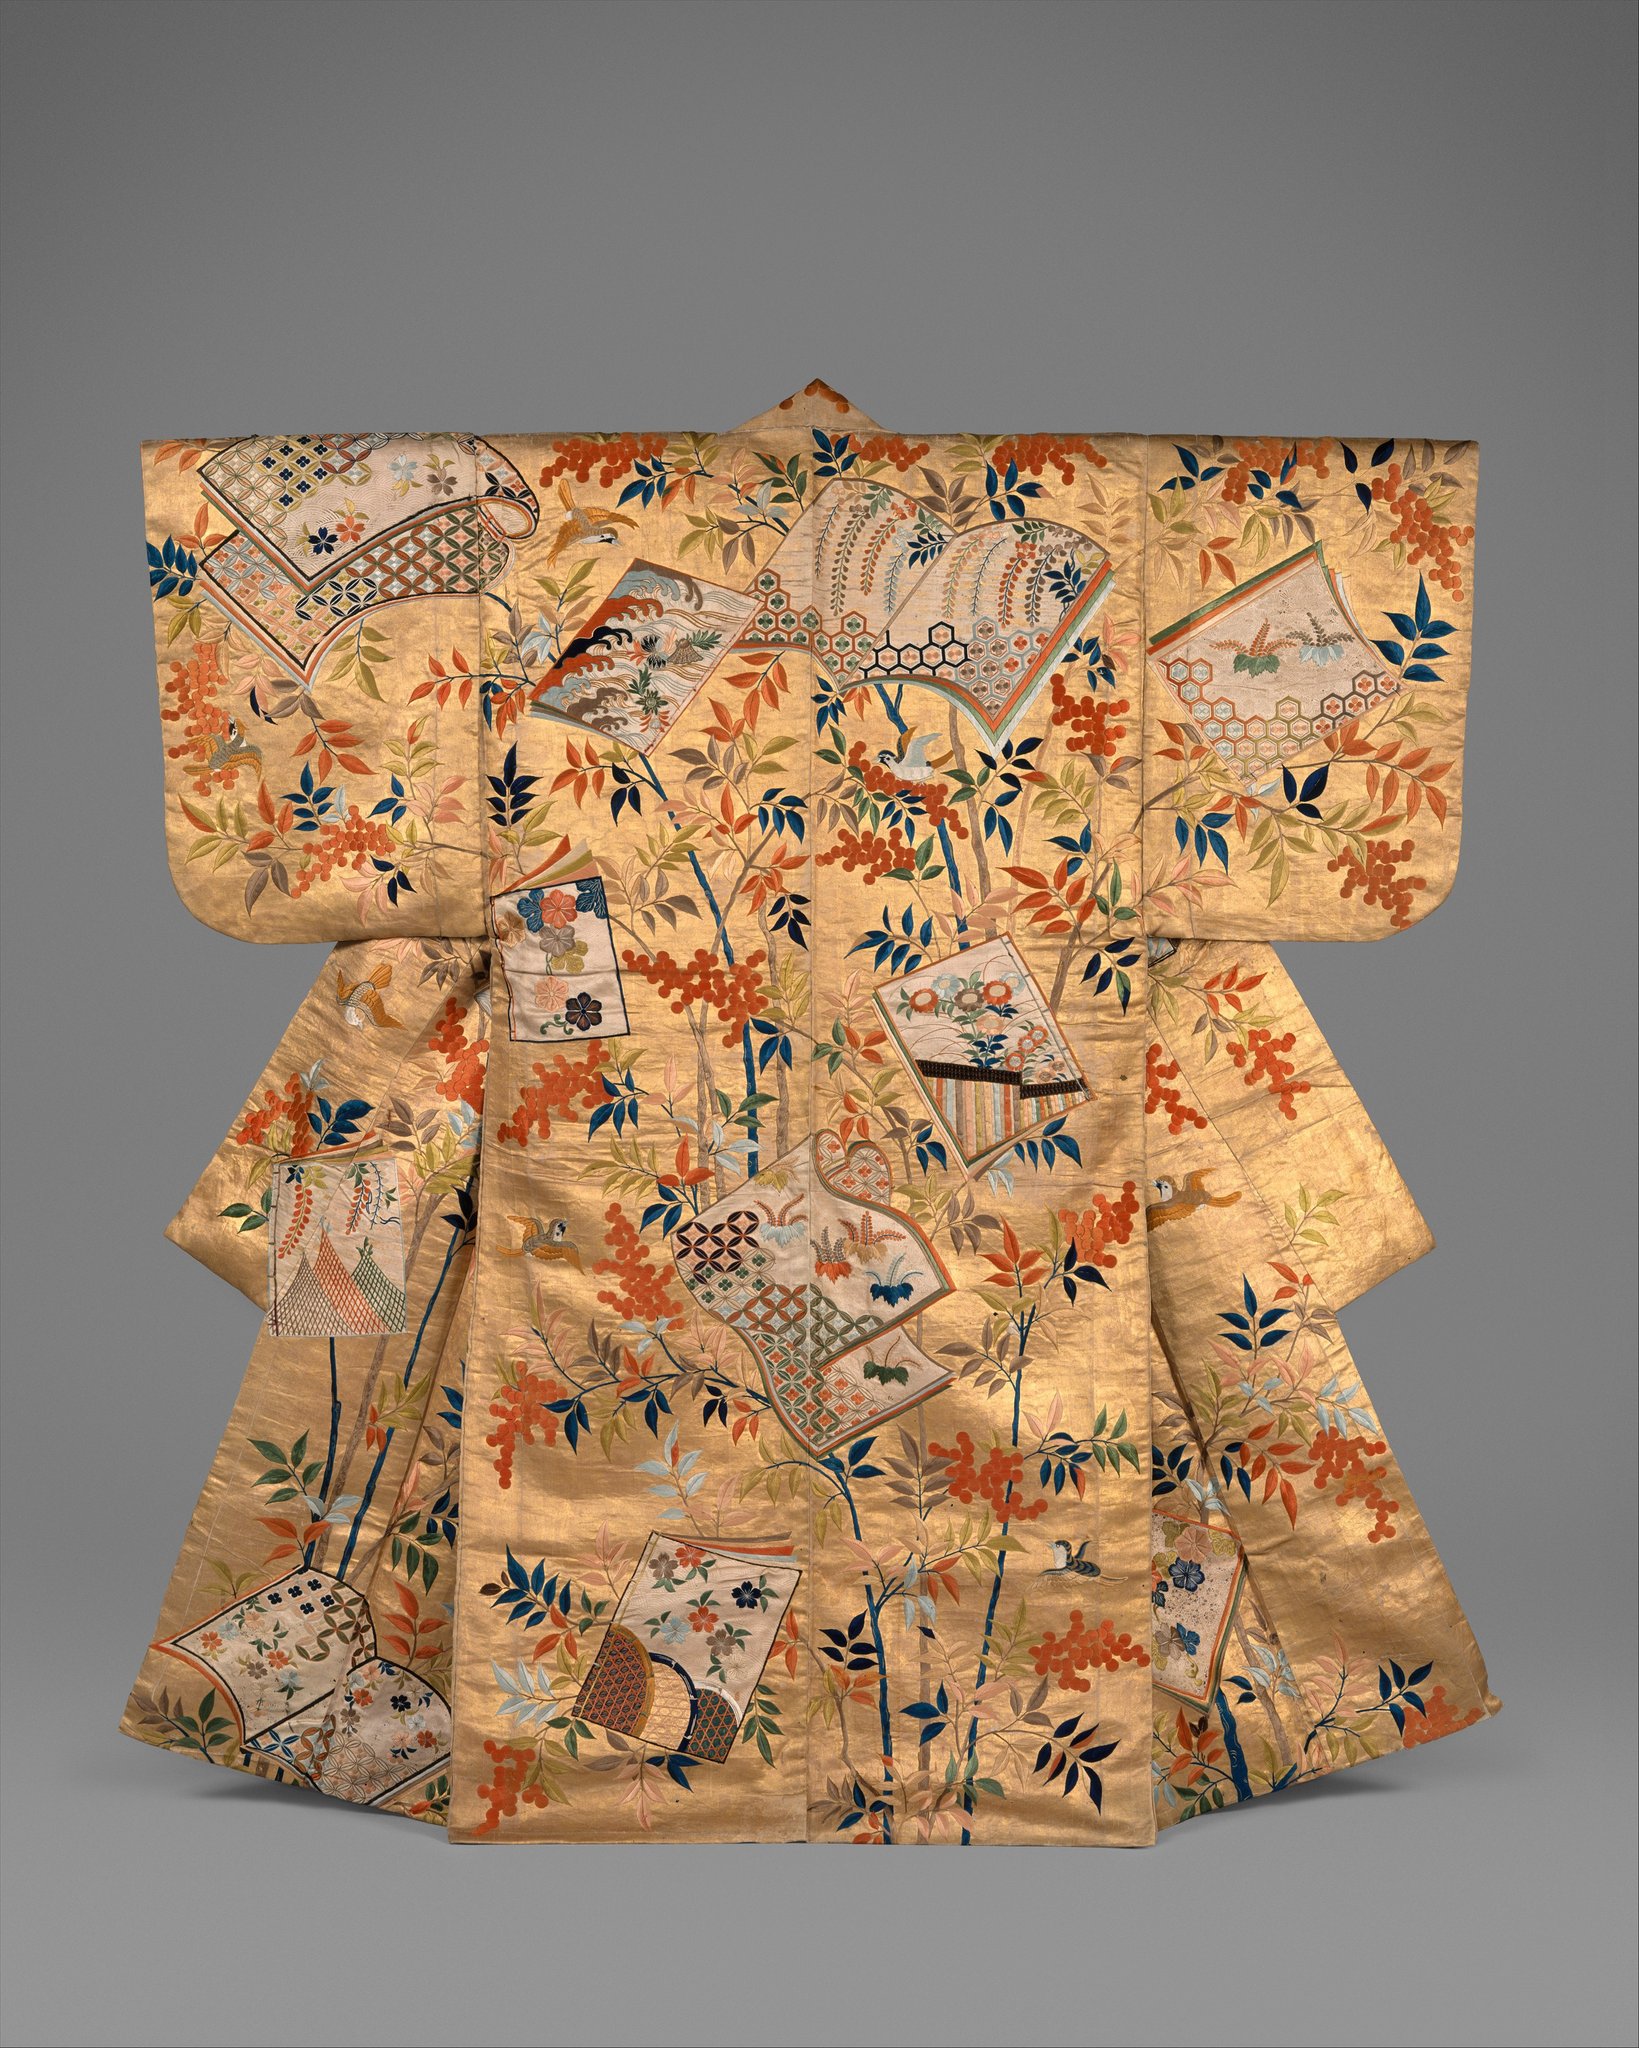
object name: noh costume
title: Noh Costume (Nuihaku) with Books and Nandina Branches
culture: japanese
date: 1751-1800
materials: silk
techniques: embroidery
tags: books,leaves